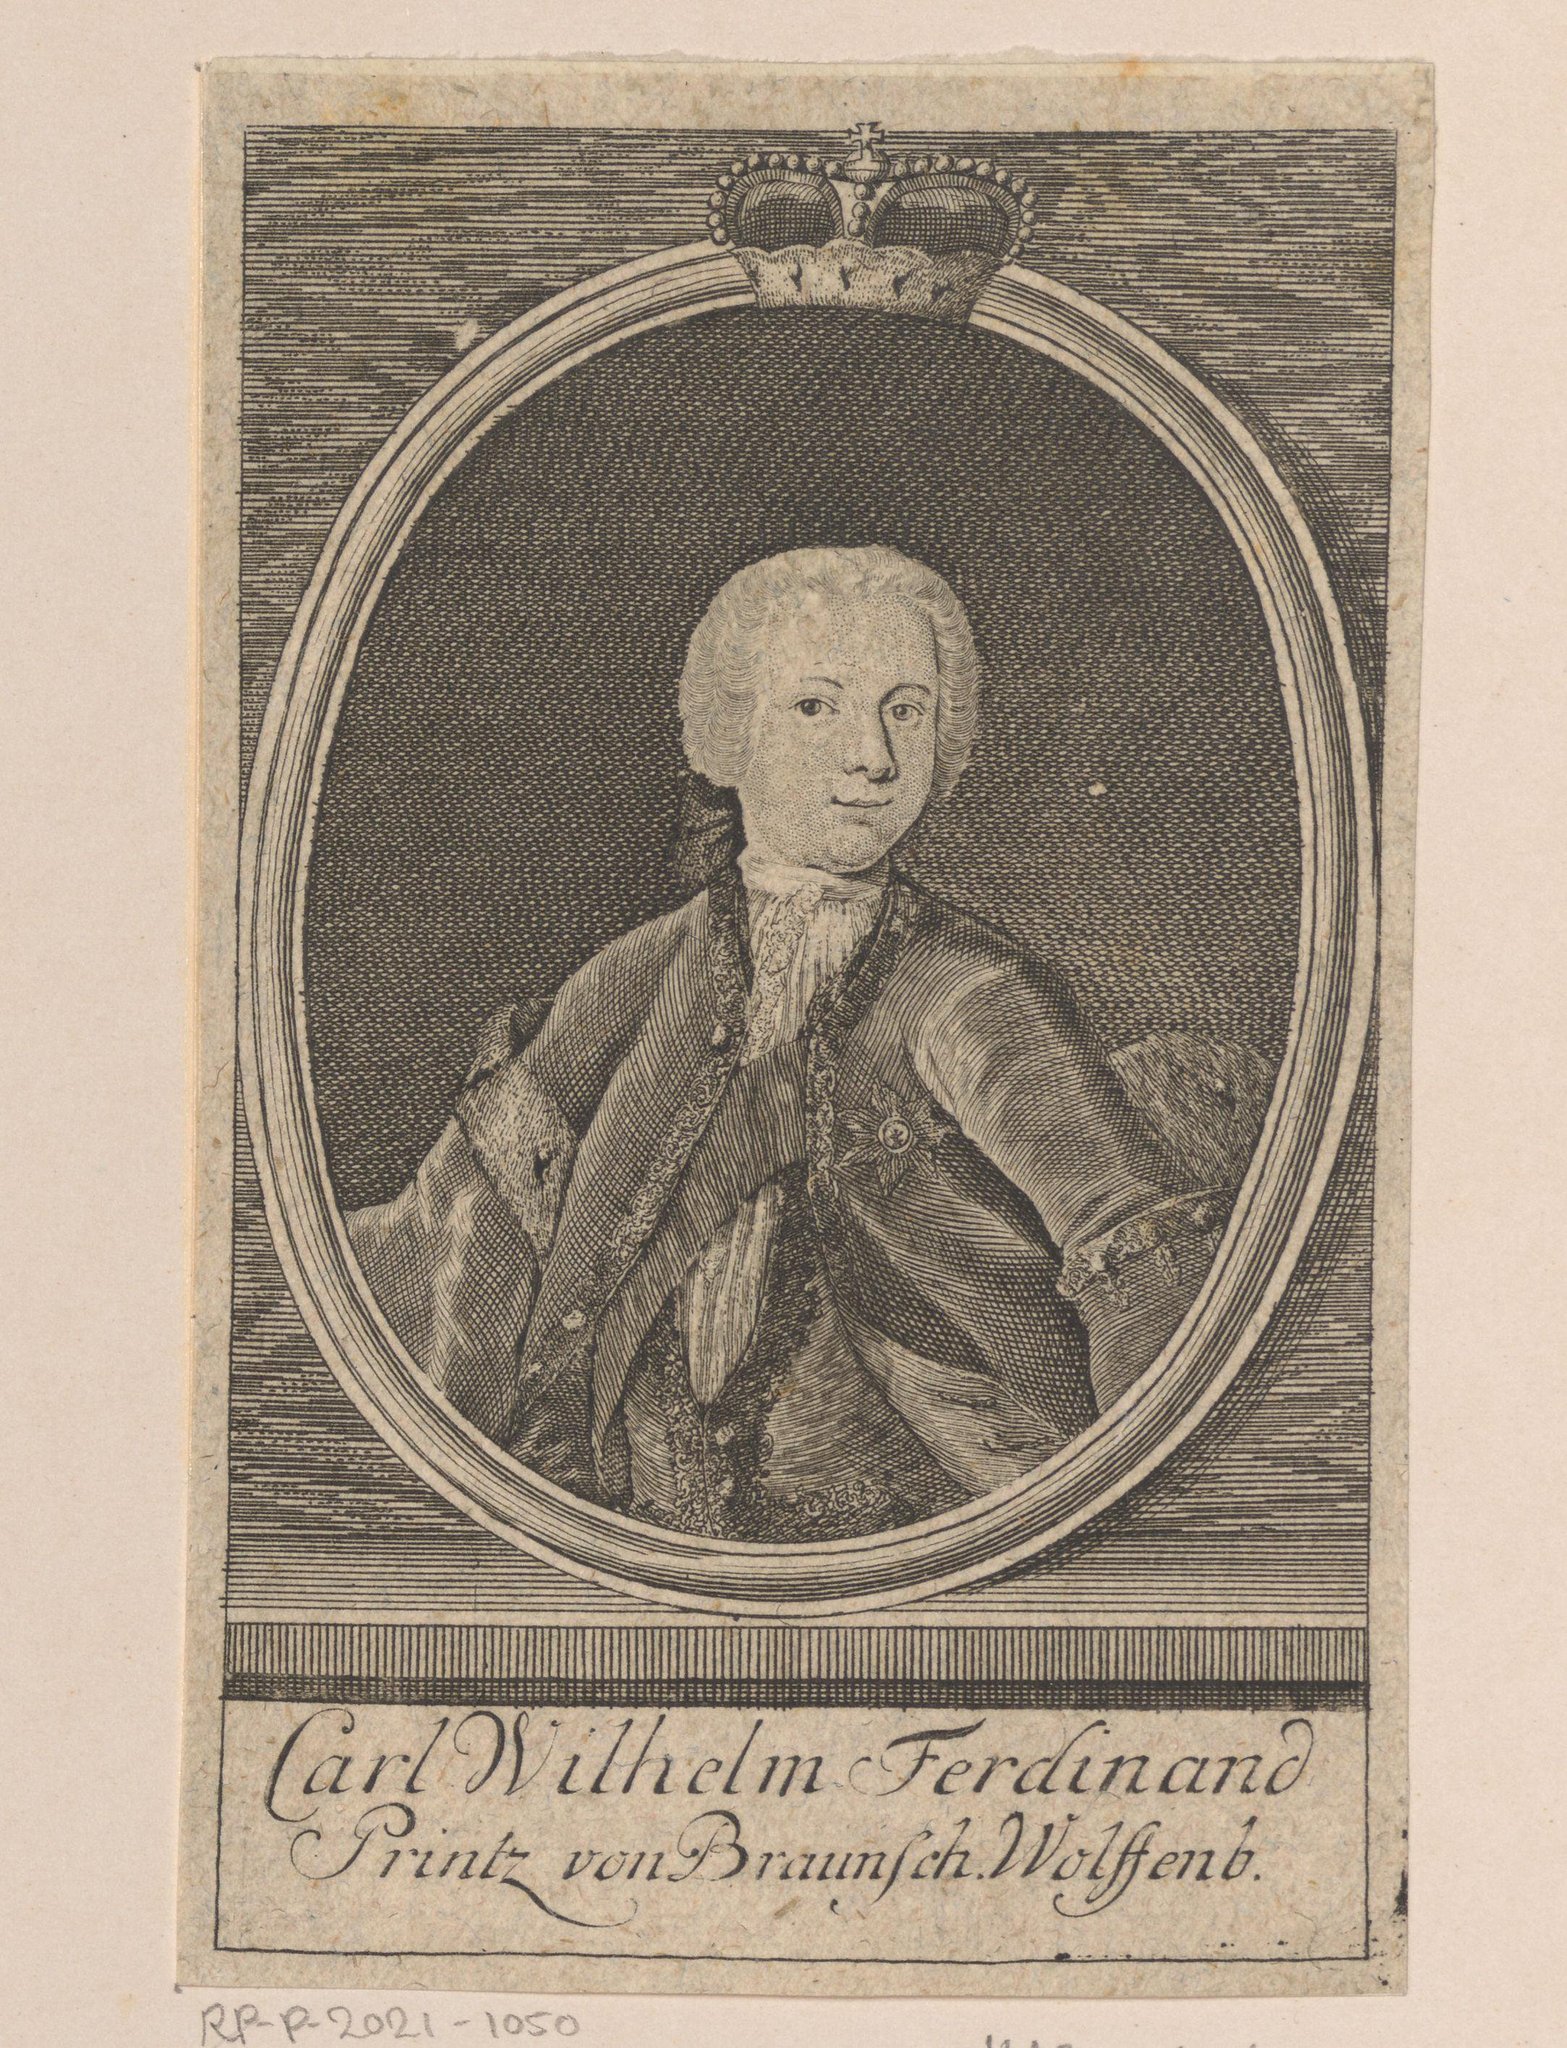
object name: print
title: Portret van Karel Willem Ferdinand hertog van Brunswijk-Wolfenbüttel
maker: johann martin bernigeroth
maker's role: print maker, publisher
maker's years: 1713-1767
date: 1745-1756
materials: paper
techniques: engraving, etching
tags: karel willem ferdinand hertog van brunswijk-wolfenbüttel, historical persons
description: Prent mogelijk uit: Europäischer Staats-Secretarius (...). Leipzig: Weidmann, 1745. Of een latere editie (1756).